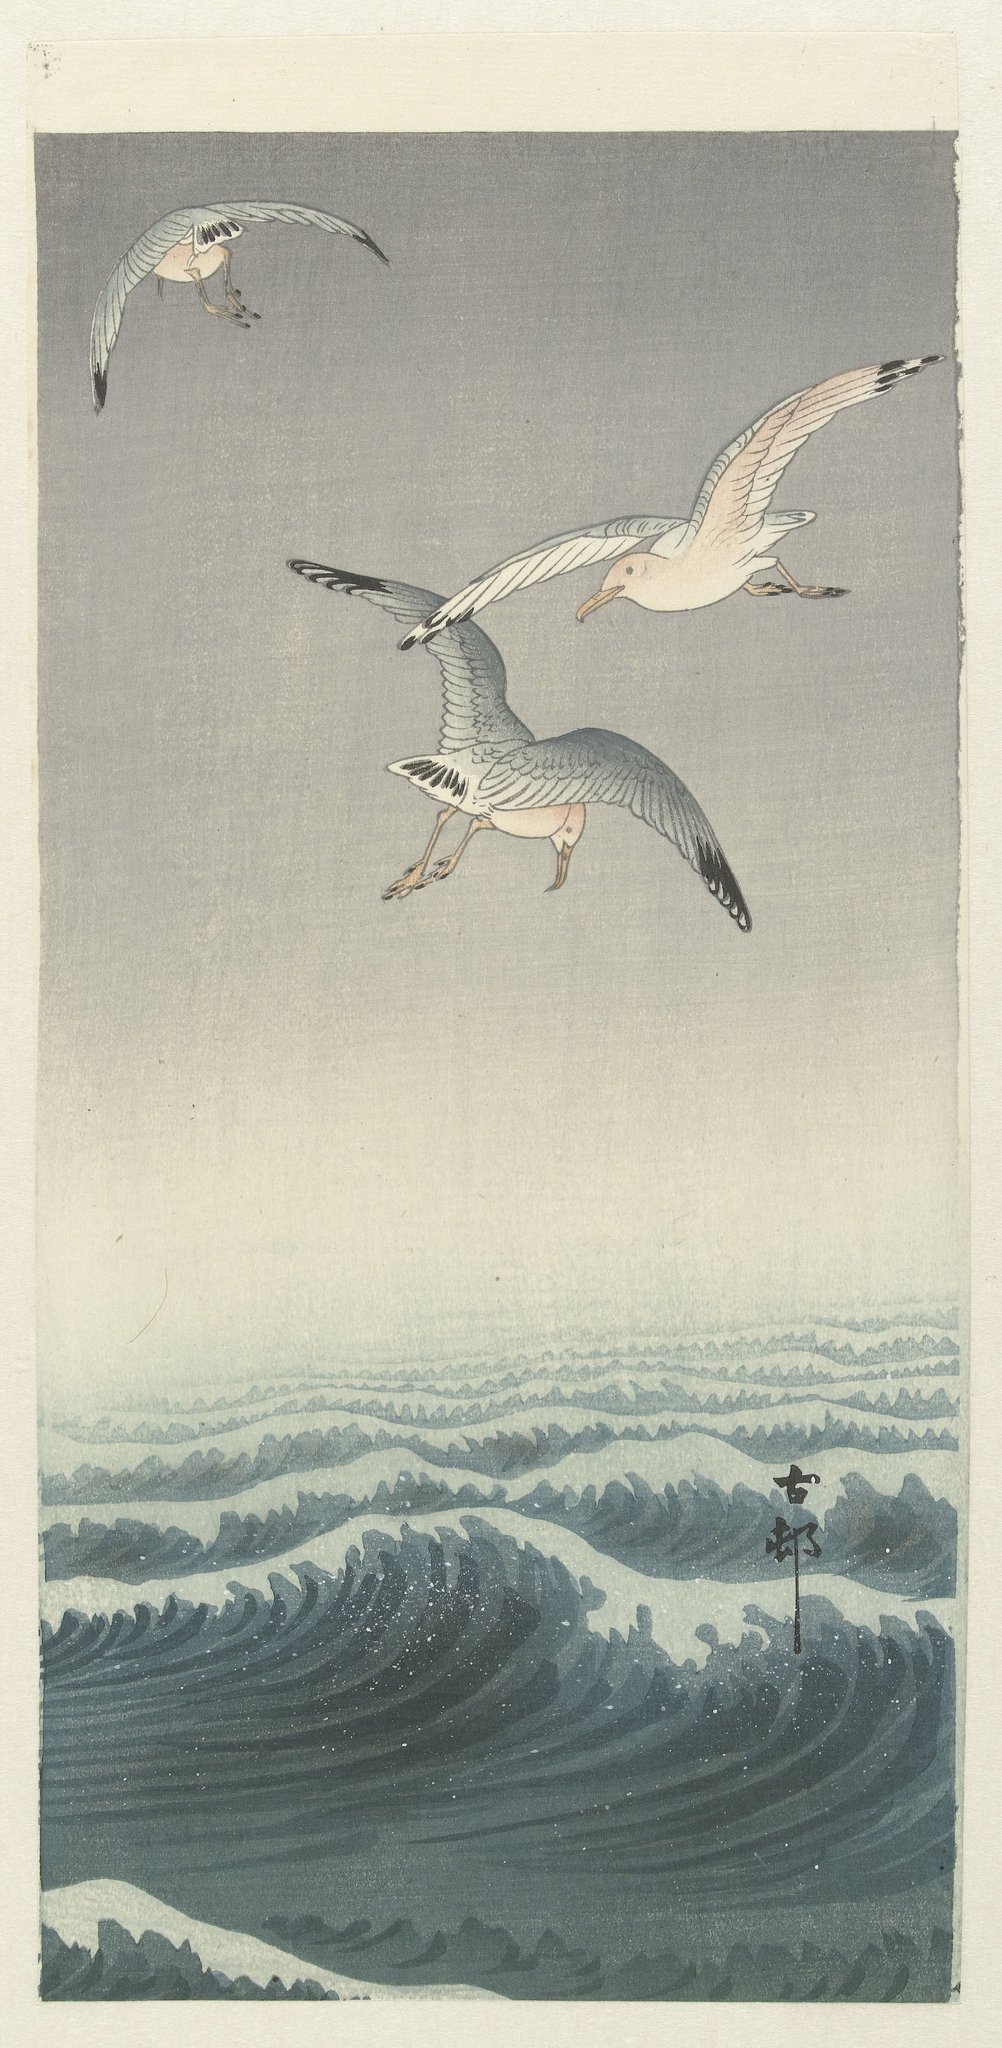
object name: print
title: Drie meeuwen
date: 1900-1936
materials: paper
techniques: woodcut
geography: japan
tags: shore-birds and wading-birds: gull, sea (seascape)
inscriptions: collector's mark: Lugt 2228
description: Drie meeuwen in vlucht boven woelige zee.